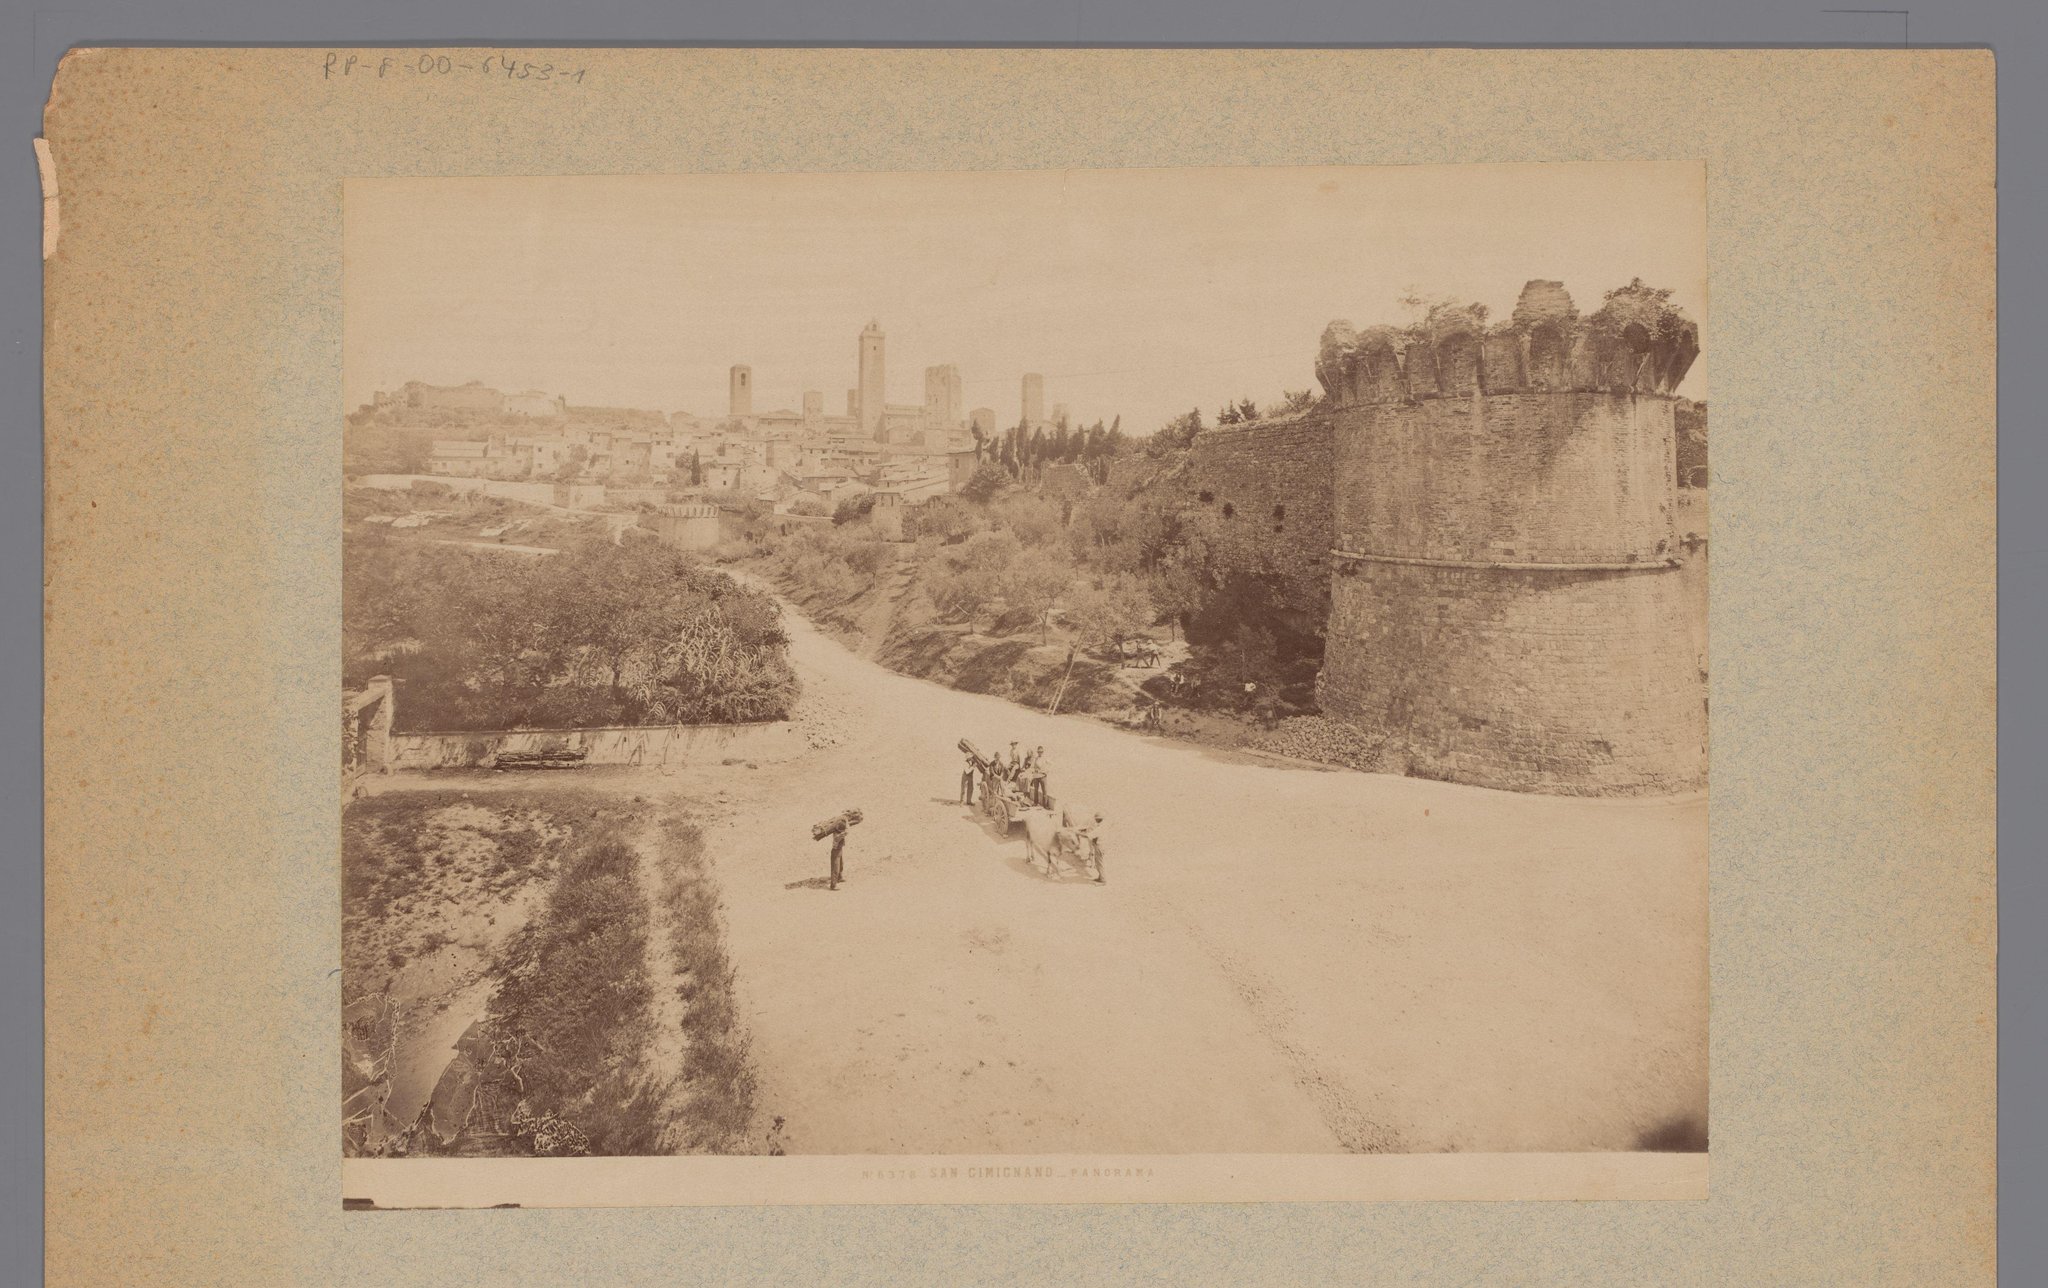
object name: photograph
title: Panorama van San Gimignano, Toscane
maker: Anonymous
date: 1870-1900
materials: cardboard, paper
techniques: albumen print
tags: san gimignano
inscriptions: inscription: ‘NOORWEGEN’, inscription: ‘No. 6378 San Gimignano - Panorama’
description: Stadsgezicht met een weg en een oude burcht/stadsmuur rechts voor, en op de weg mensen met paard en wagen en stapels hout op hun schouders. San Gimignano is bekend om zijn dertien torens die het silhouet van de stad domineren en waarvan er hier enkele te zien zijn. Deze zijn in de 12de en 13e eeuw door rivaliserende rijke families opgetrokken. De torens deden dienst als woning en versterking, maar vooral als prestigeobject. Op haar hoogtepunt had de stad zo'n 70 torens.